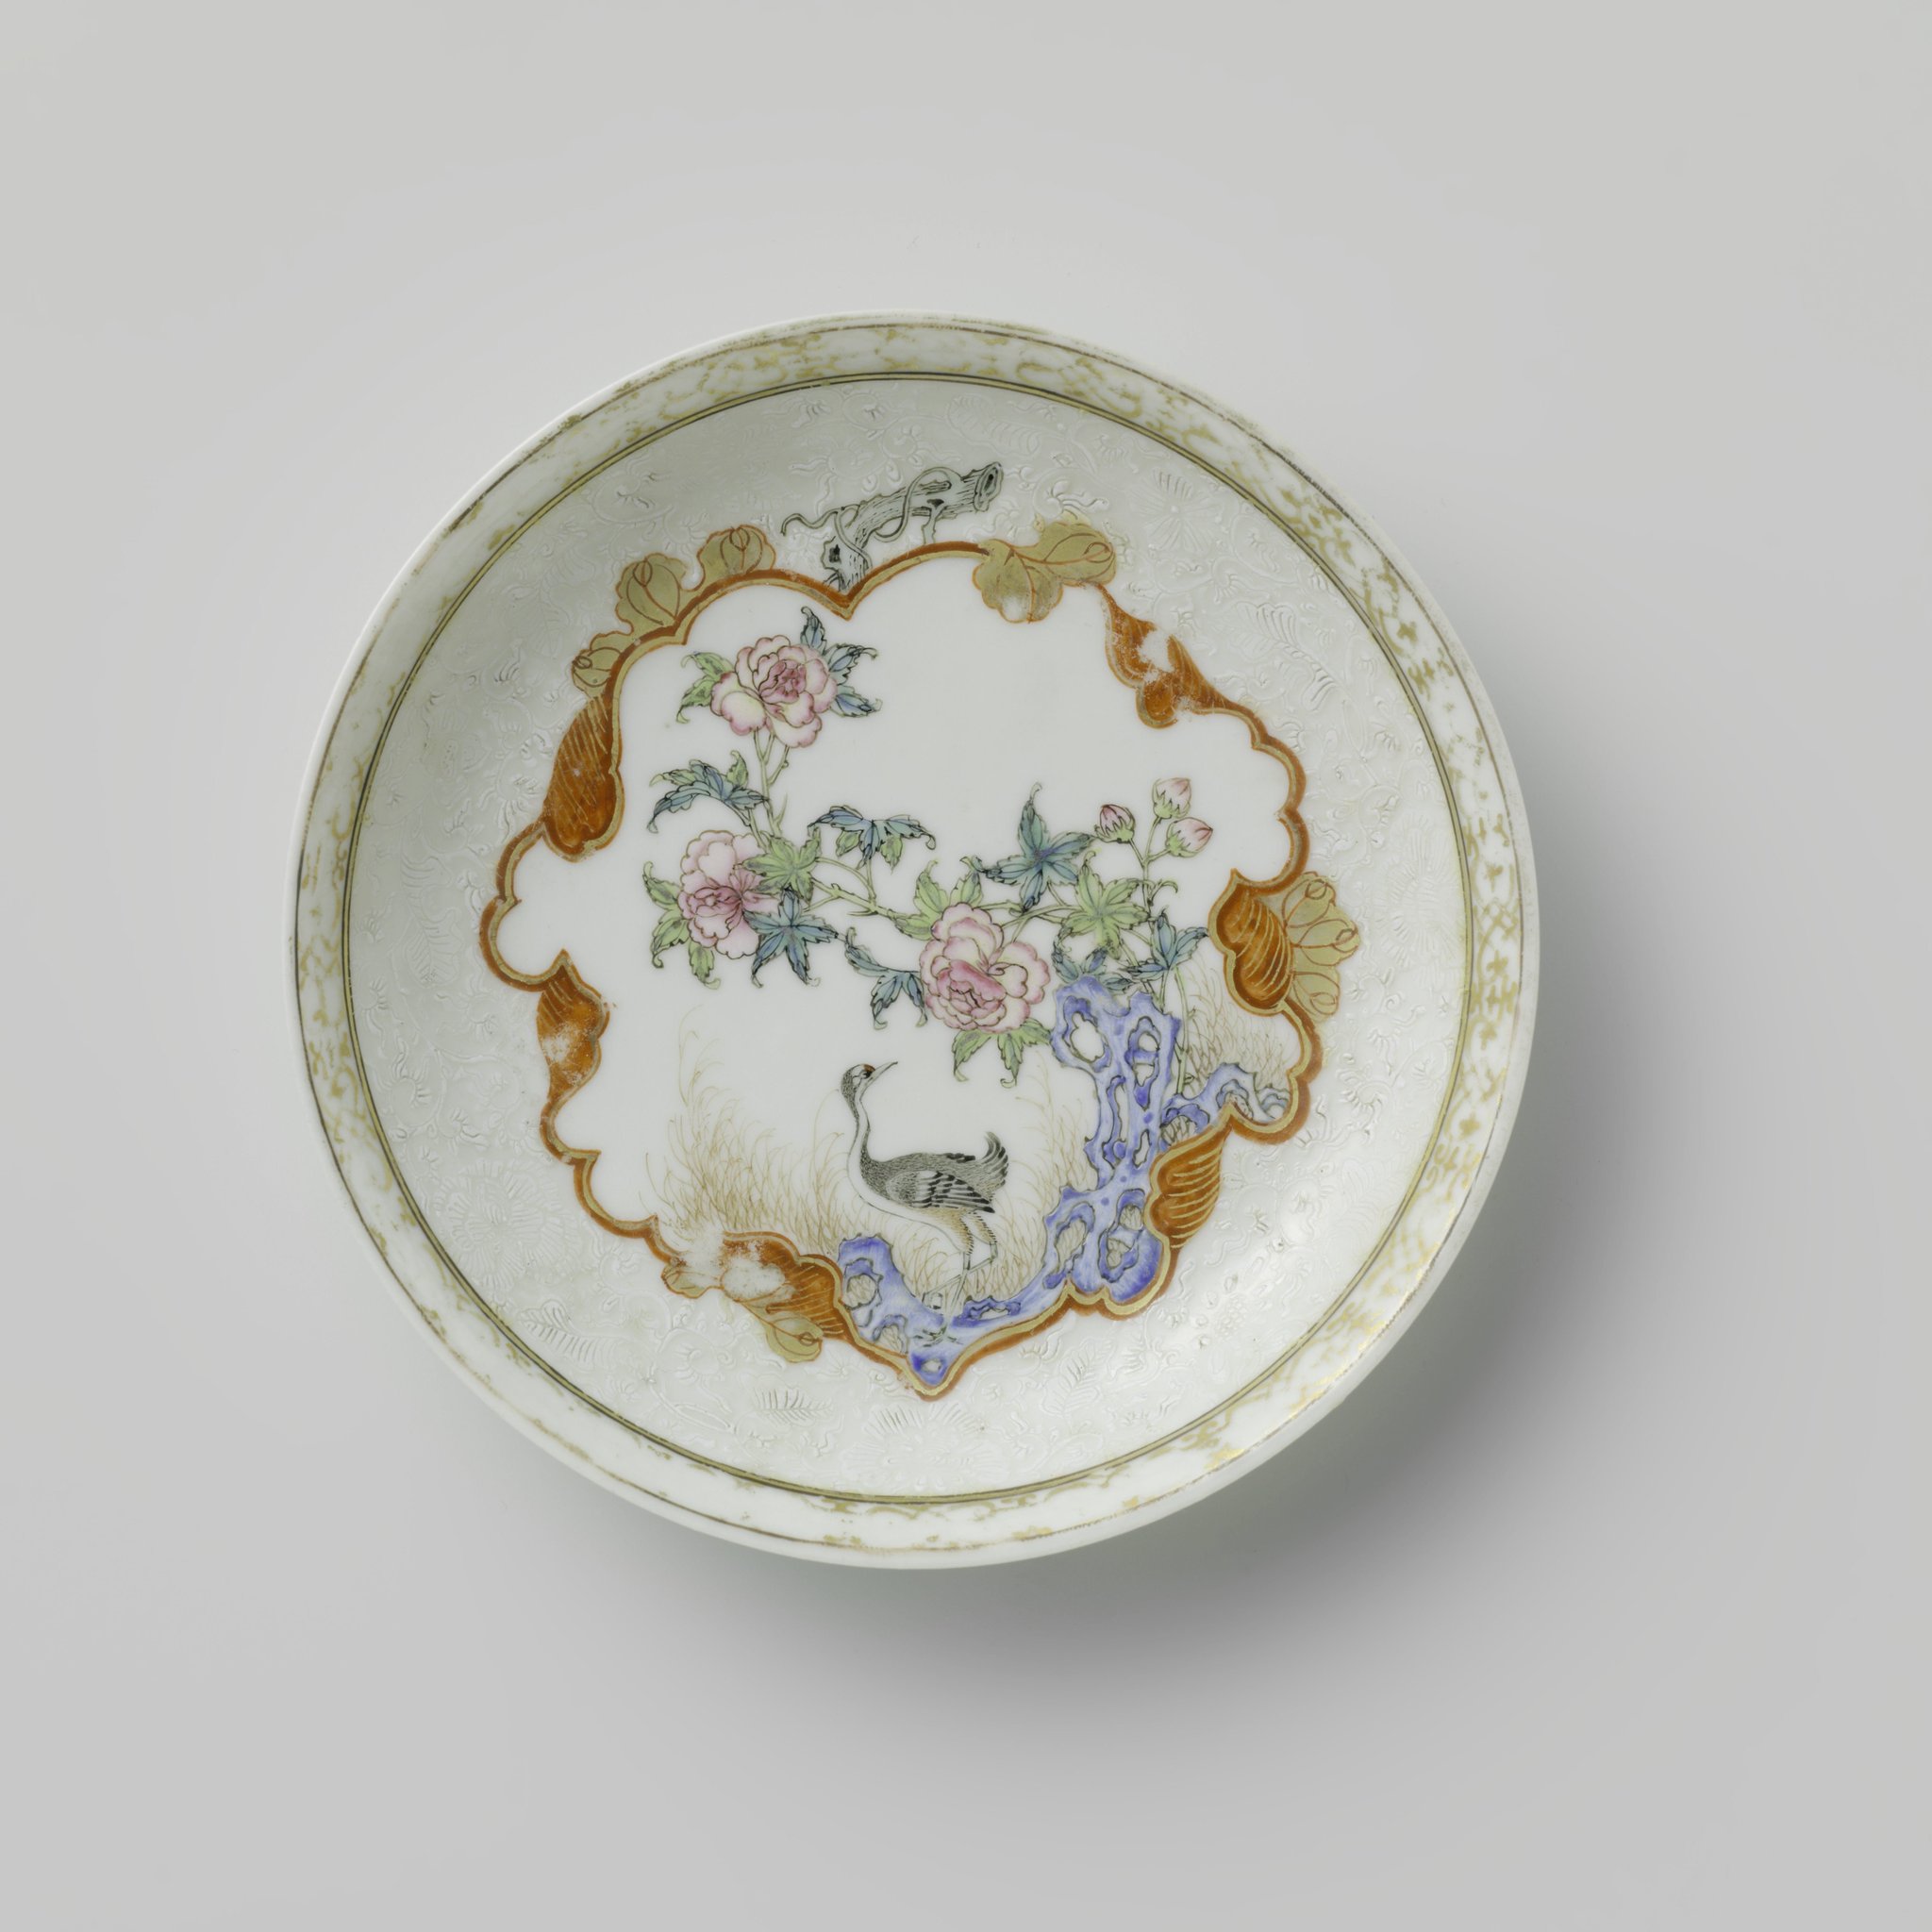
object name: platter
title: Saucer with a crane near a peony plant and rock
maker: Anonymous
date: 1725-1749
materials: glaze, gold, paint, porcelain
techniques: firing, gilding, turning, vitrification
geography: china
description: Gedecoreerd in emails, goud en bianco sopra bianco met vogels en bloeiende planten.